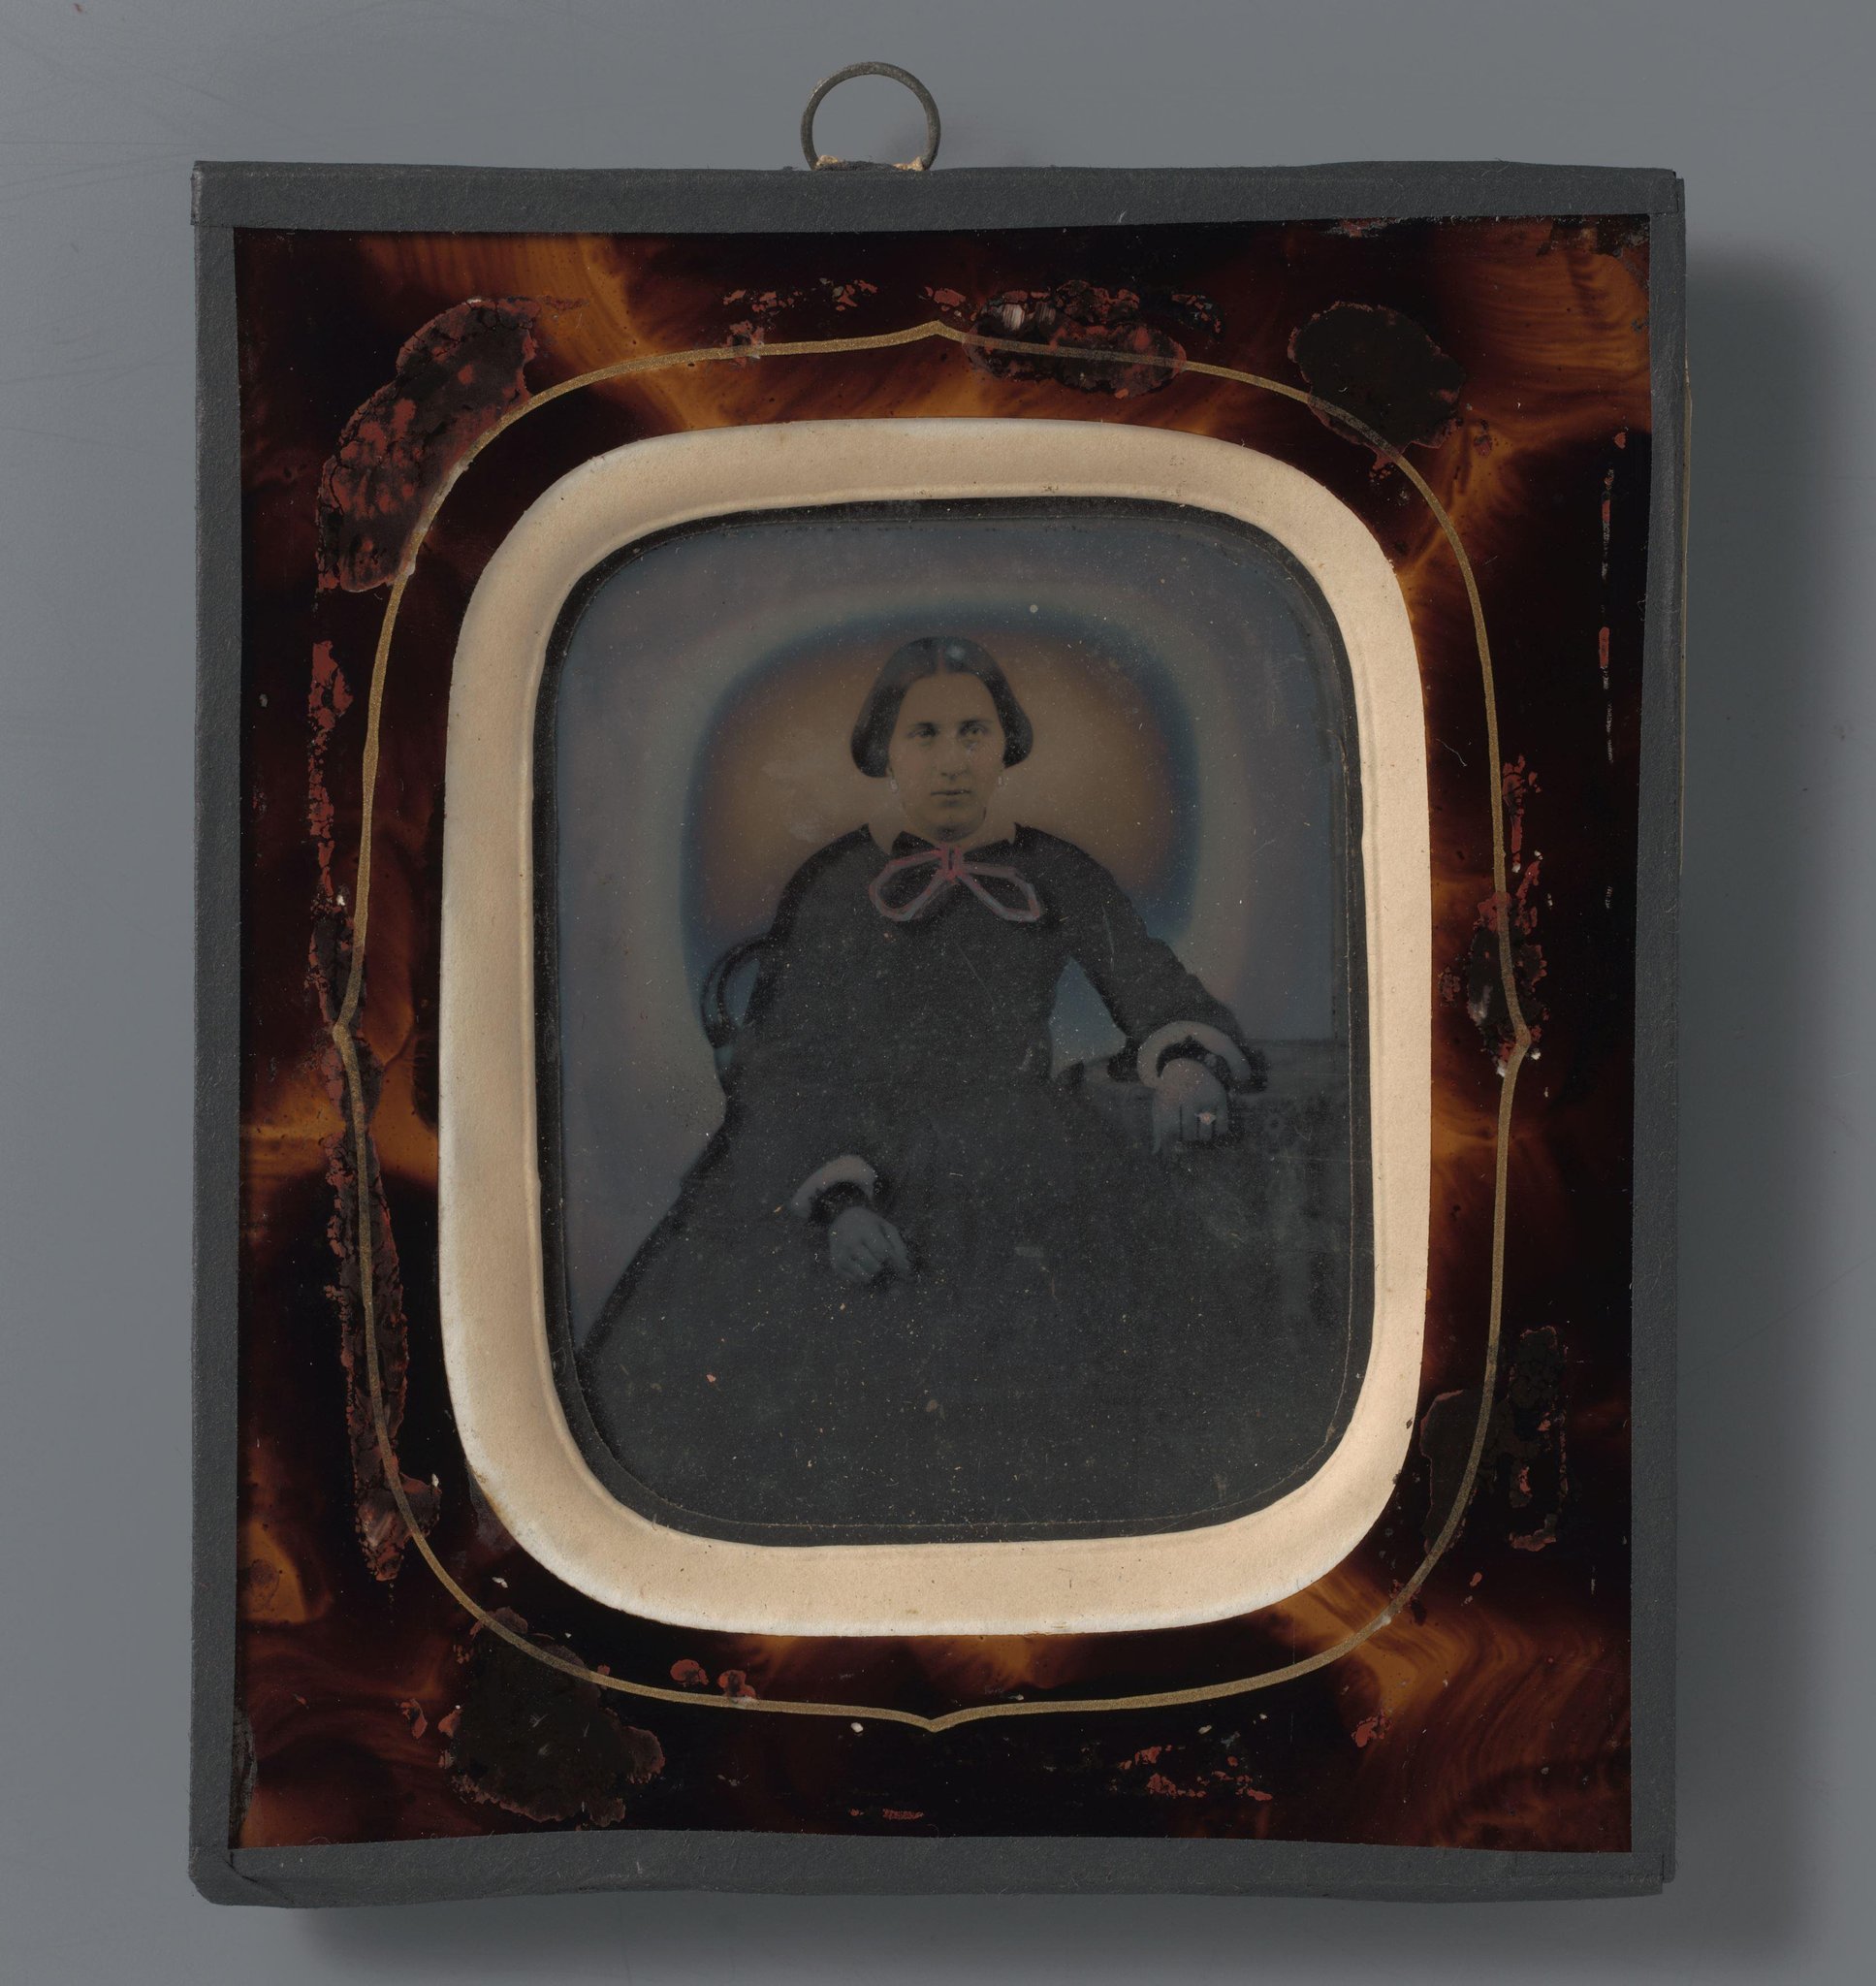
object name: frame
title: Portret van een onbekende zittende vrouw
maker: kaiser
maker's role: fotograaf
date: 1855-1870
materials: cardboard, glass, metal, paper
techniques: ambrotype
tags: sitting figure - aa - female human figure, historical persons - bb - woman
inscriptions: inscription: ‘[...] JEANNE-[..]ACDETTE/ [A] coté du cimetiè[re] [...] Roca/ HAVRE/ Près la Brasserie de M. J. Loue[...]/ HAVRE/ KAISER/ FAIT LA/ Photographie sur Verre, Toile et Papier./ Portraits depuis 50 Cent./ J'ai l'honneur d'informer (...) on ne voudraient/ se déranger./ On demontre la Photographie pour [...]/ prix de 25 Fr.’